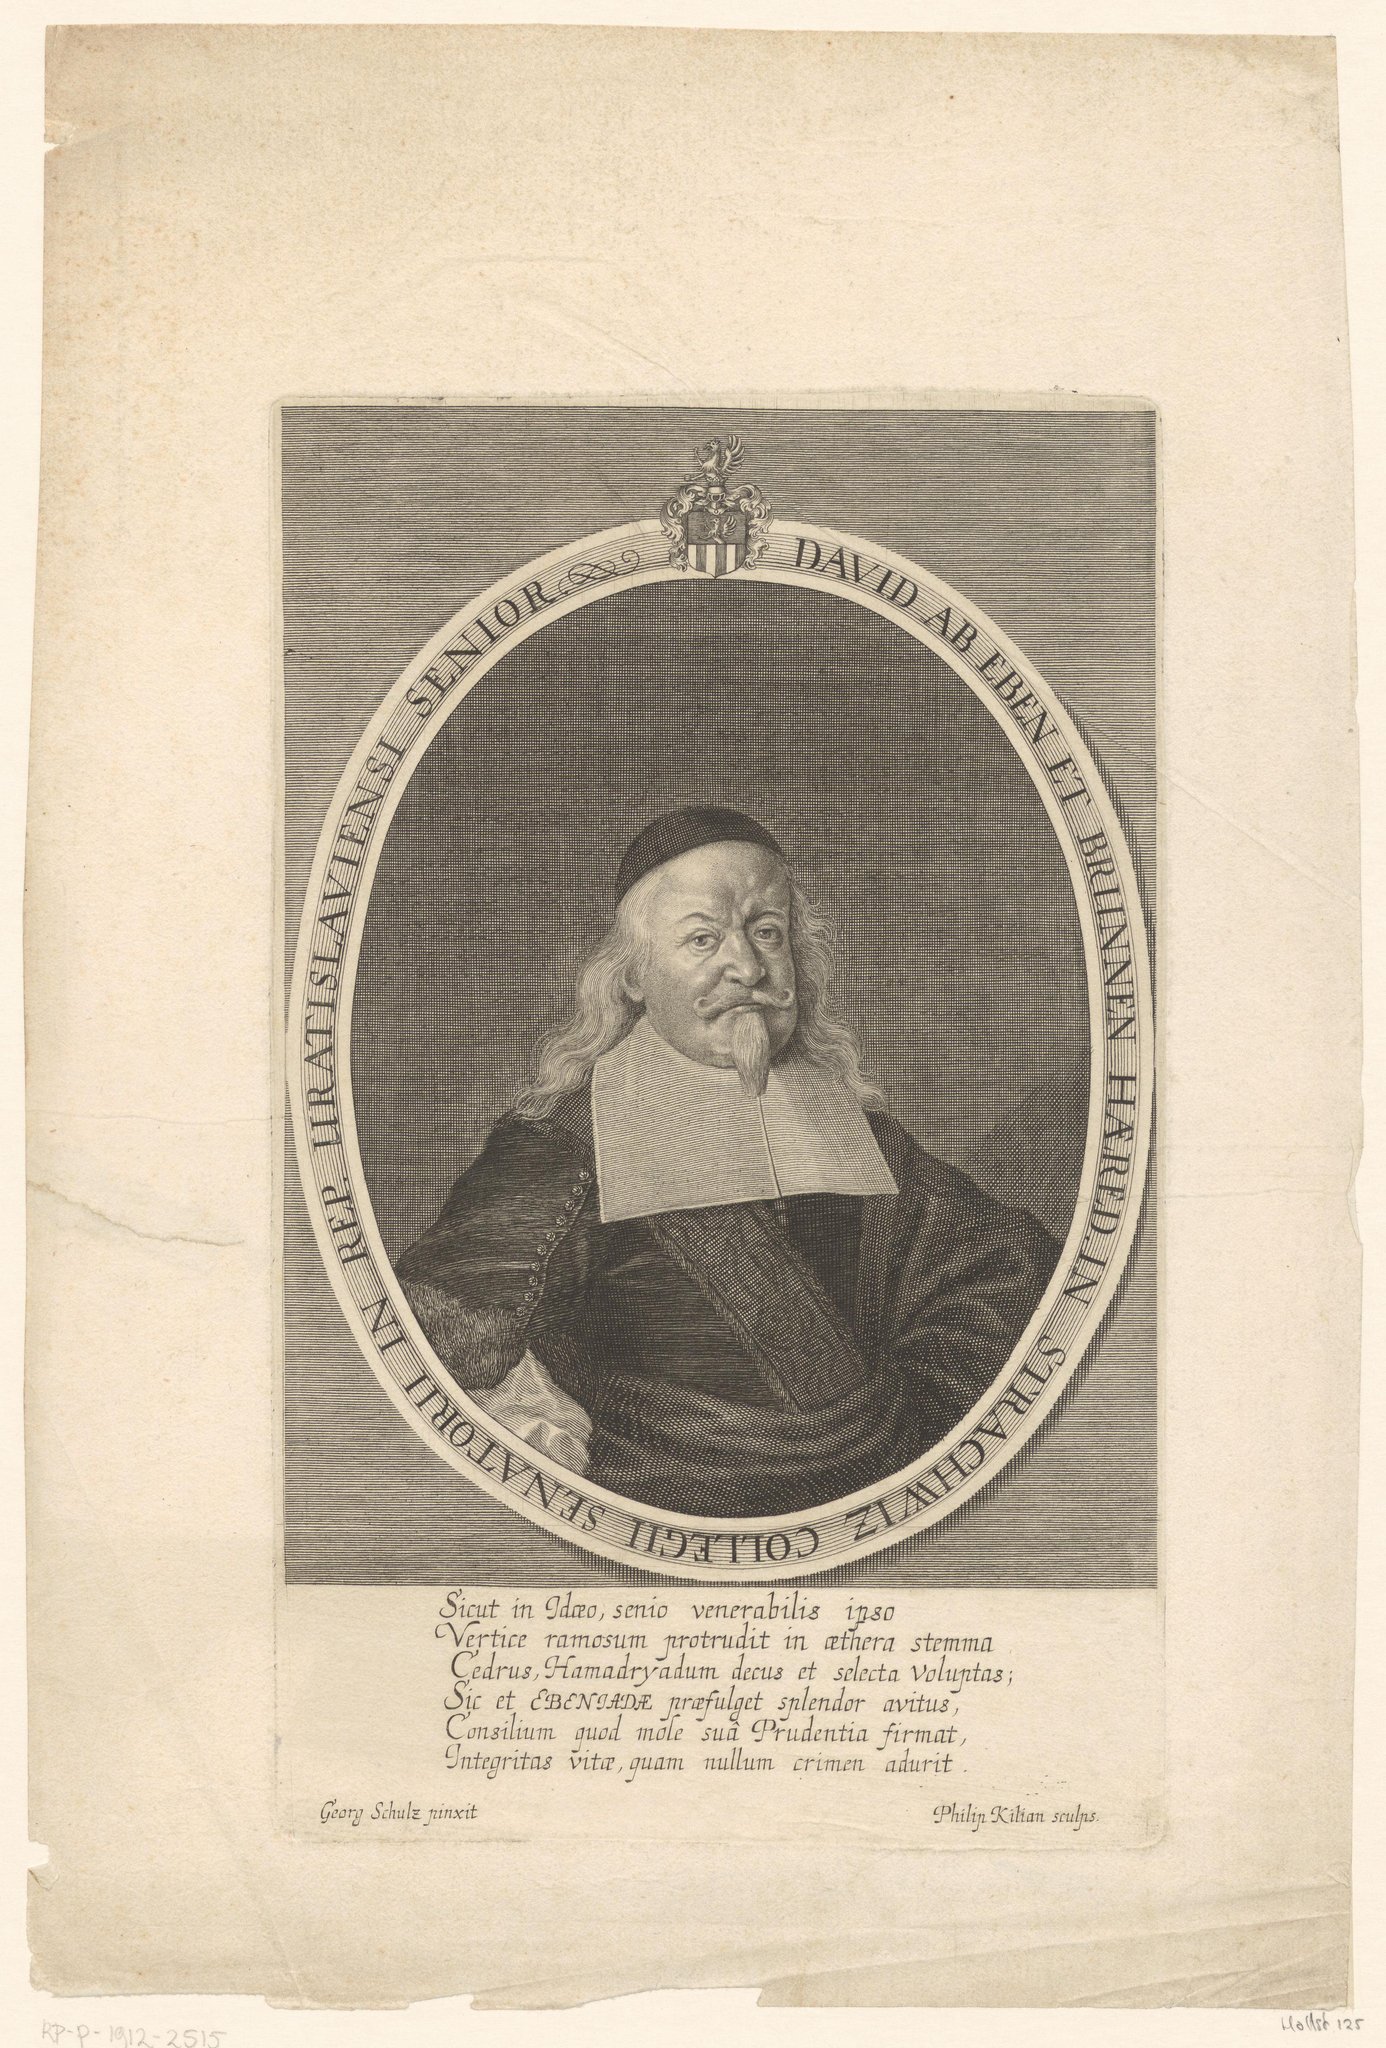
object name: print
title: Portret van David von Eben und Brunnen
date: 1638-1693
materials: paper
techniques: engraving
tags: historical persons, counsellor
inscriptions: collector's mark: Lugt 2228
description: Tekst in het Latijn in de omlijsting en in de ondermarge.